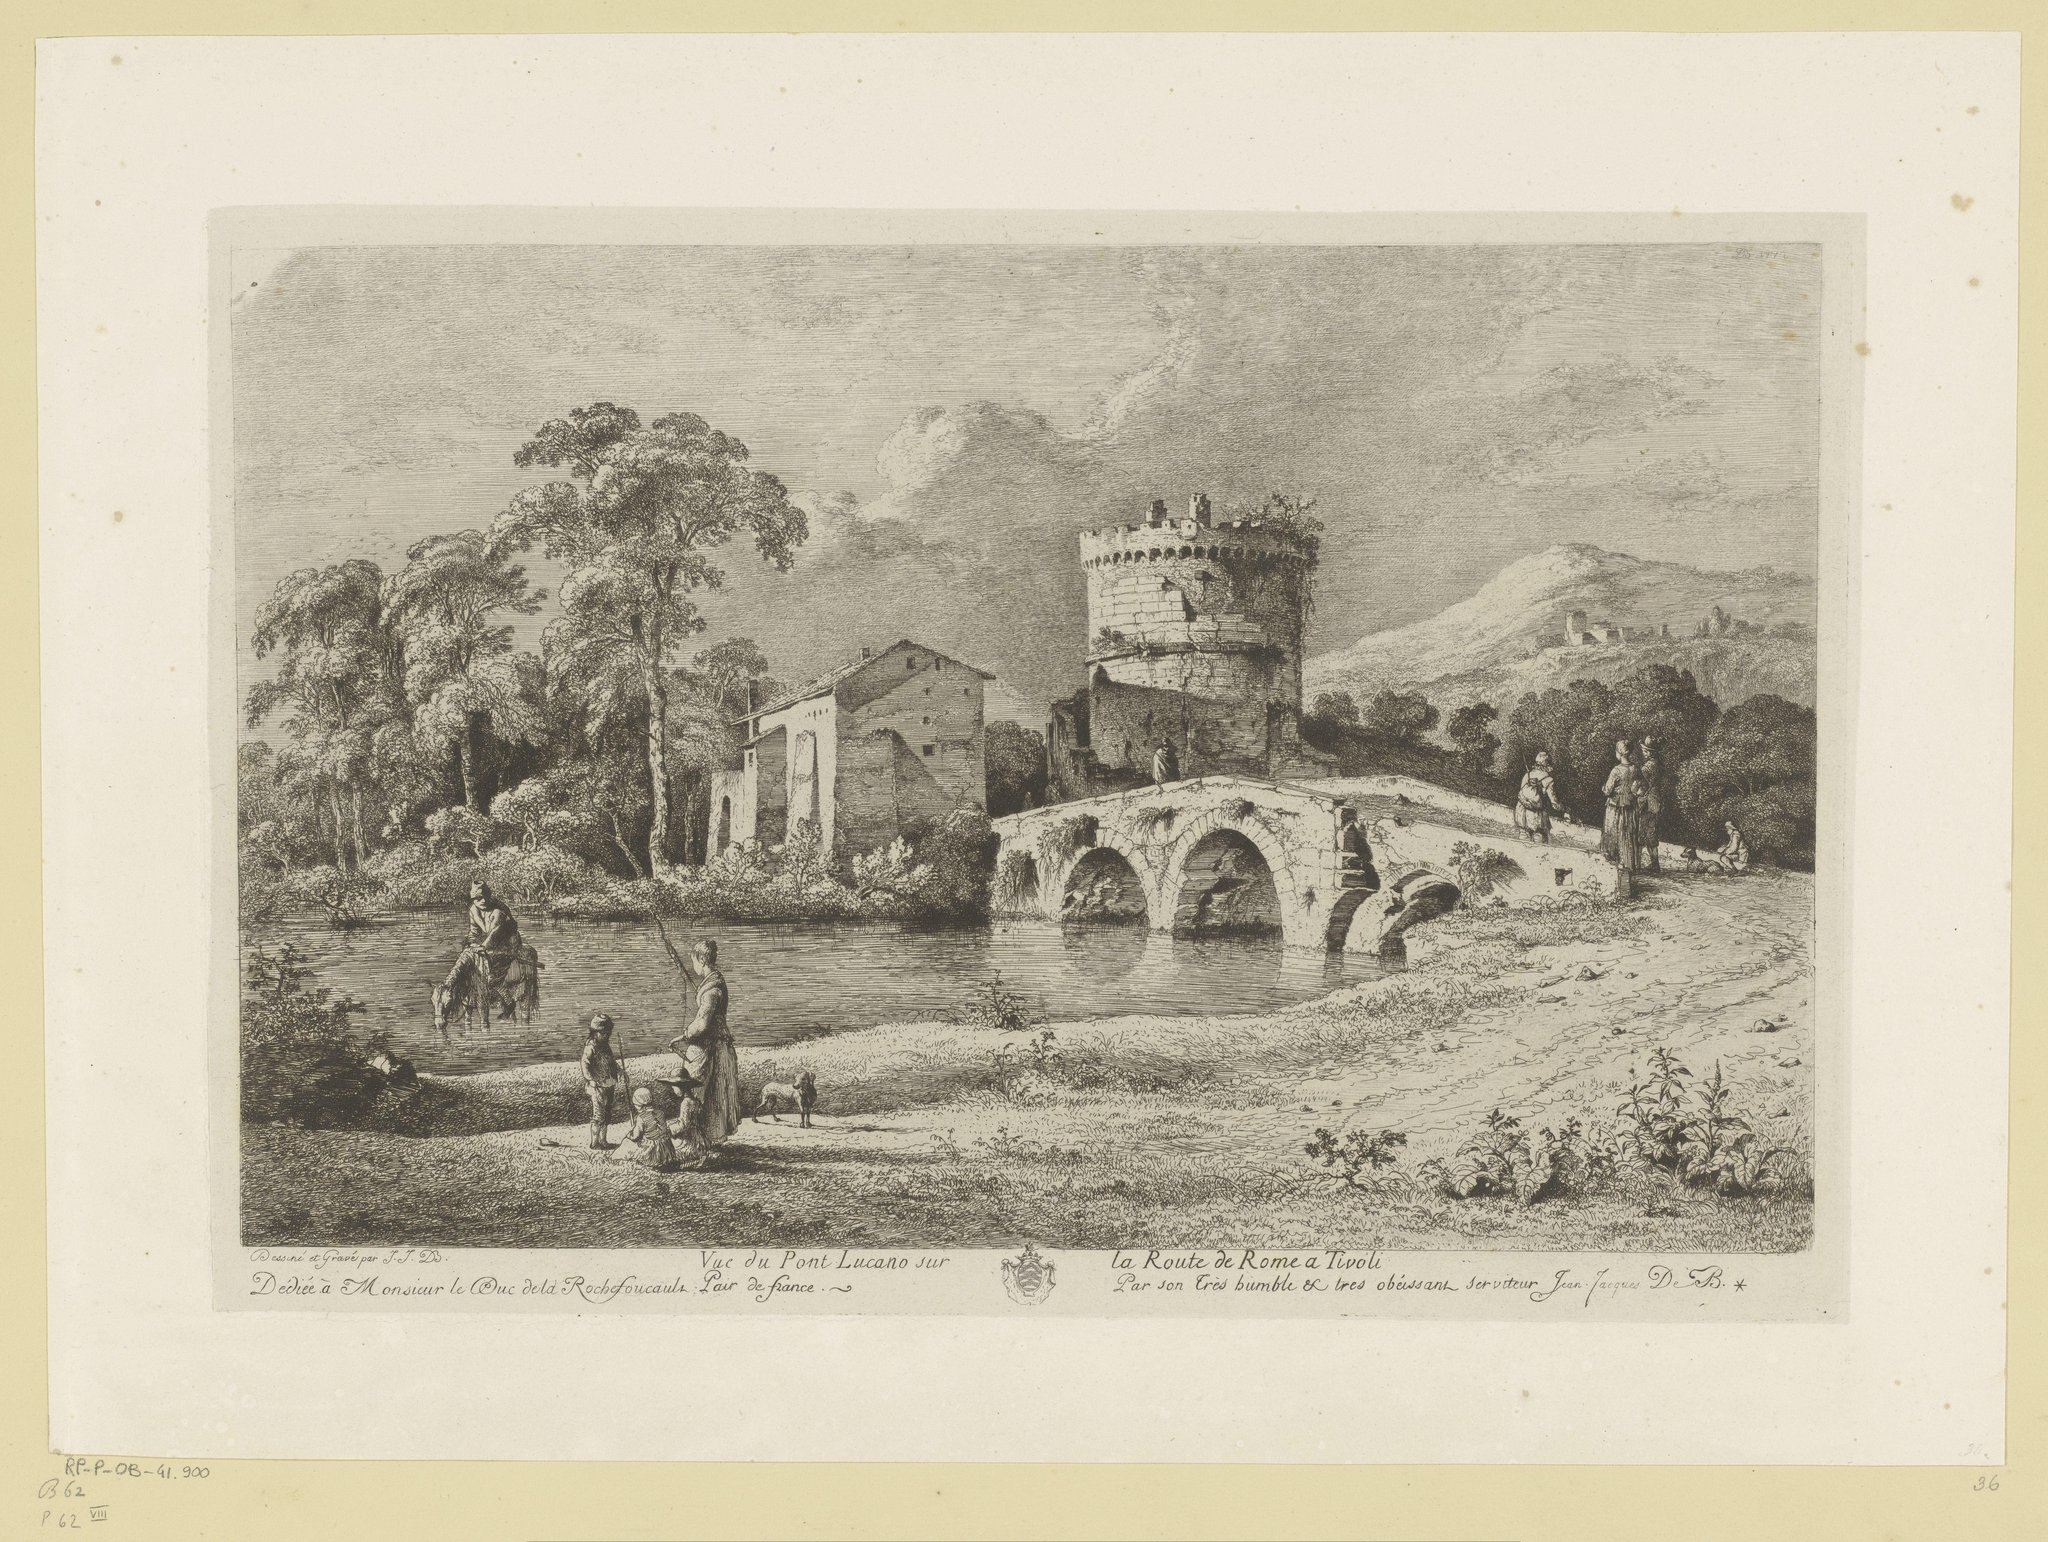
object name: print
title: Vue du Pont Lucano sur la Route de Rome a Tivoli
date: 1772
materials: paper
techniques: drypoint, etching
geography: france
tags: landscape with bridge, viaduct or aqueduct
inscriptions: collector's mark: Lugt 12